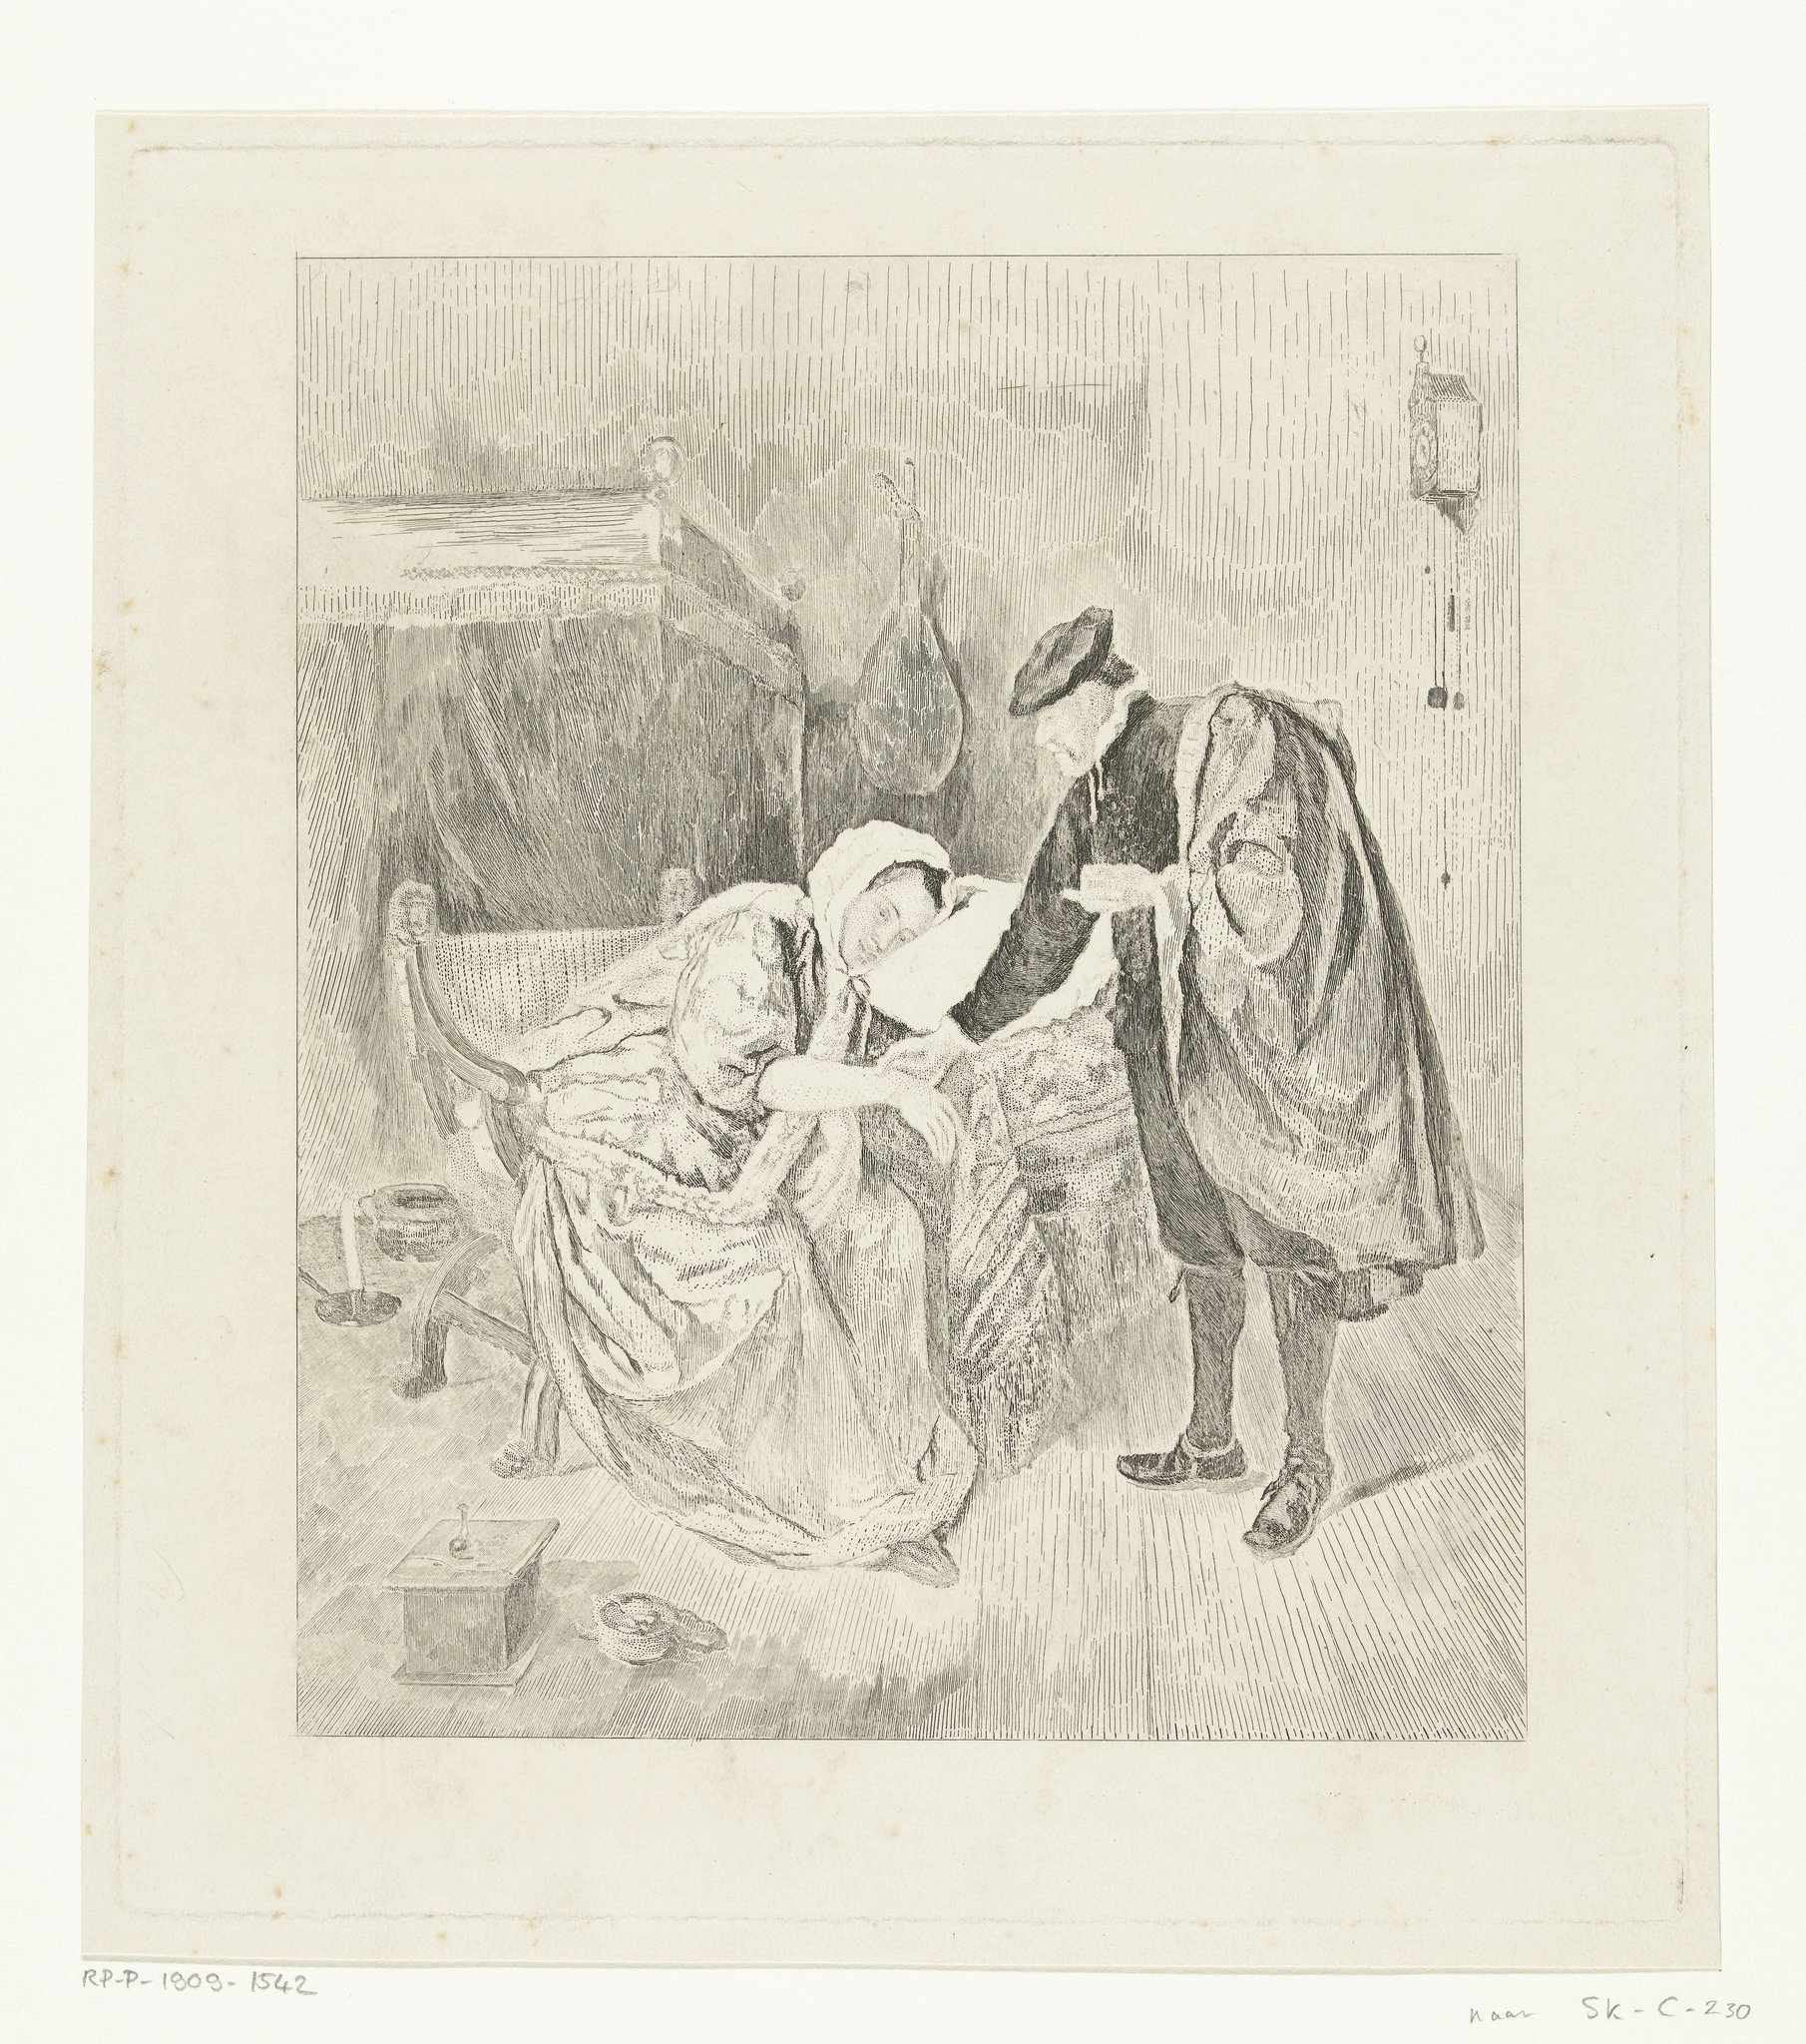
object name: print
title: De zieke vrouw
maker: johannes arnoldus boland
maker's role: print maker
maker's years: 1838-1922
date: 1860-1900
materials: paper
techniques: etching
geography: amsterdam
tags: feeling pulse or heart-beat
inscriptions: collector's mark: Lugt 2228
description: Coll. de la Faille. Reproductie van een schilderij uit de collectie van het Rijksmuseum Amsterdam, SK-C-230.